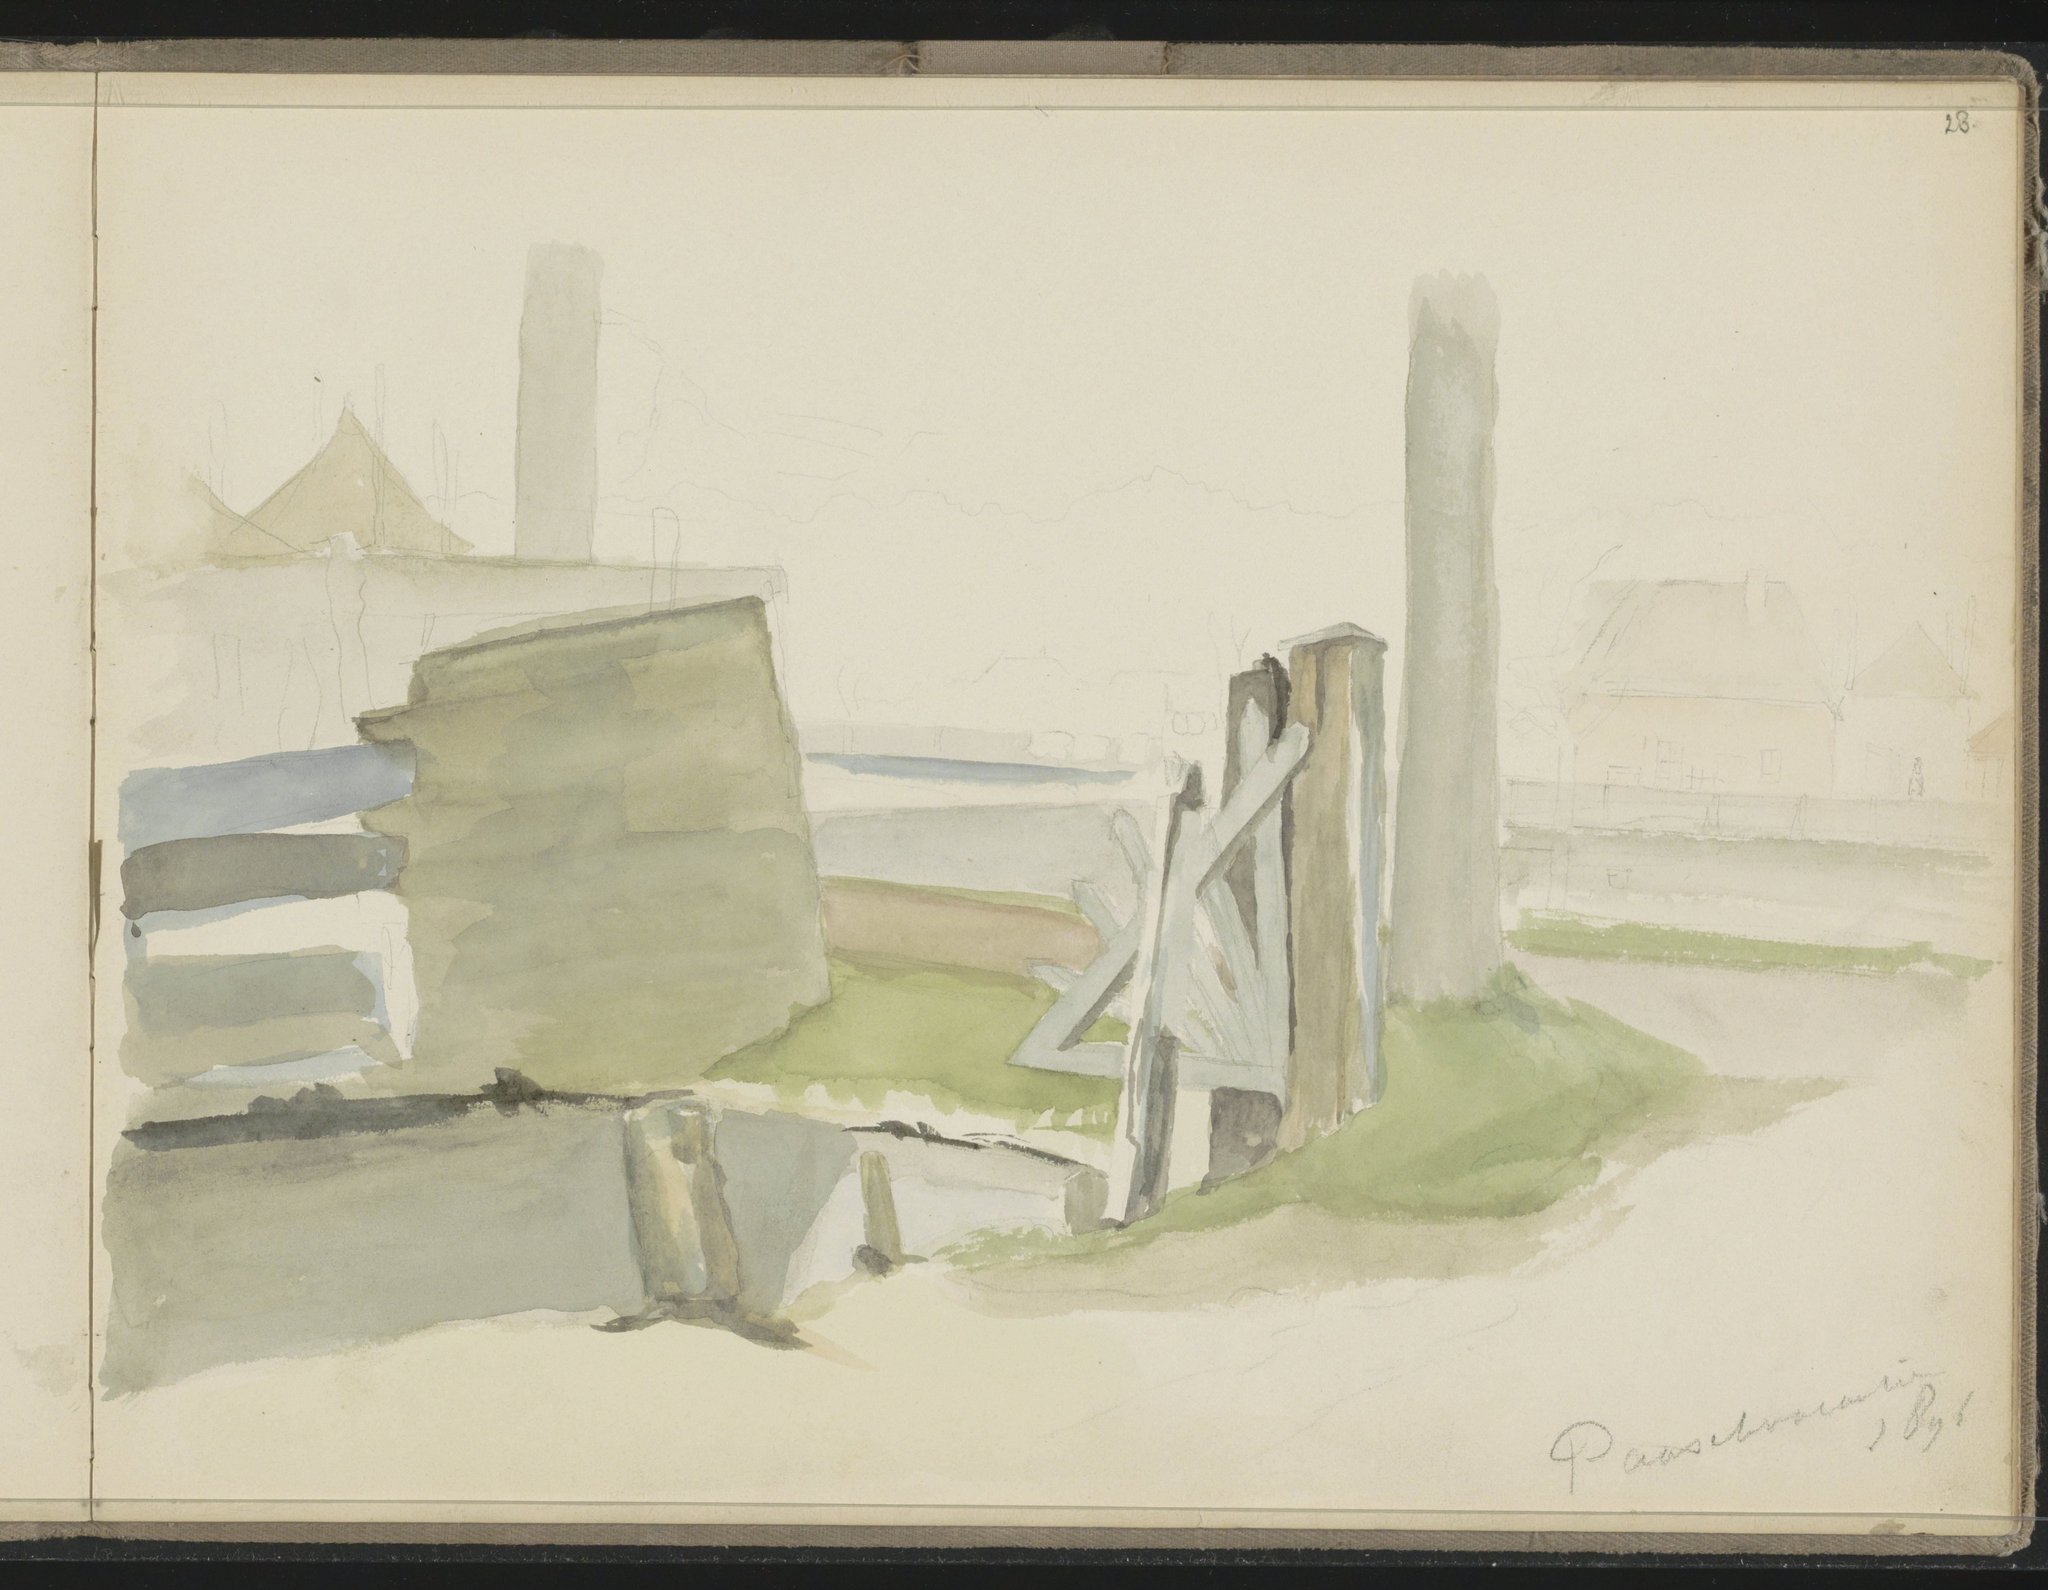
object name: sketchbook leaf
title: Pad langs een kanaal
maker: chris huidekooper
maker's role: draughtsman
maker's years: 1878-1939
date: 1804-1896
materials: paper, pencil, watercolor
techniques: brush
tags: canal, road, path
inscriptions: date and inscription: ‘Paaschvacantie/ 1896’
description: Blad 23 recto uit een schetsboek met 32 bladen.